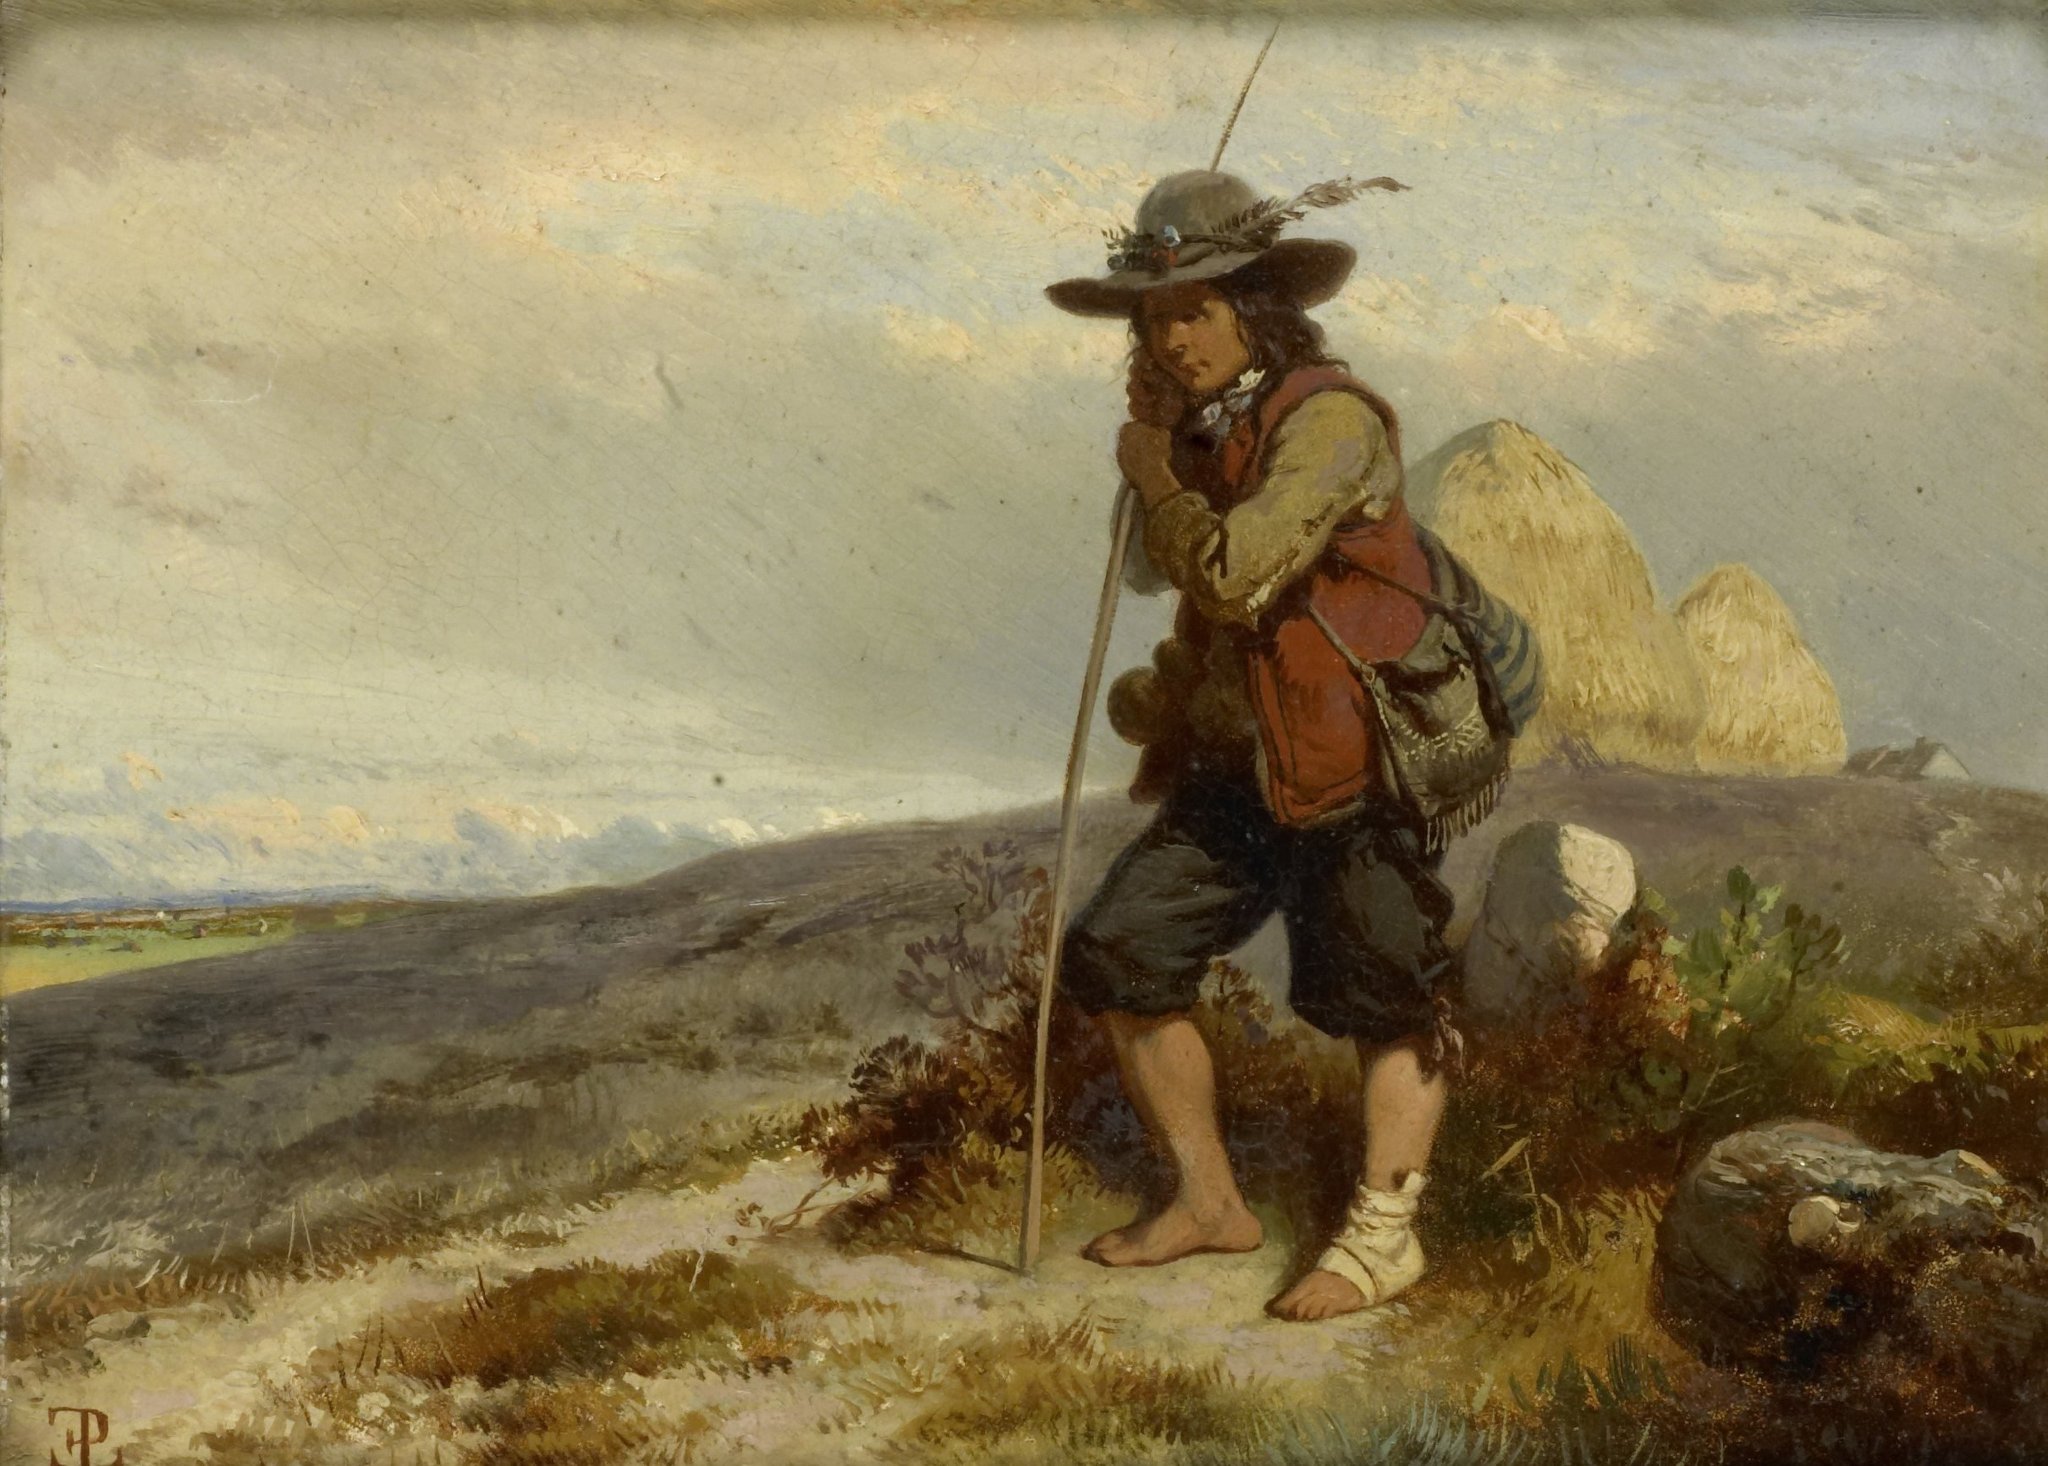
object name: painting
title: A young Herdsman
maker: eugène modeste edmond lepoittevin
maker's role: painter, print maker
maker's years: 1806-1870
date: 1840-1870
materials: board, oil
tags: herding, herdsman, herdswoman, shepherd, shepherdess, cowherd, etc., hay-stack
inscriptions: signature: ‘ELP’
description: Een herdersjongen staande op een heuveltop, leunend op zijn staf. Rechts hooibergen en een boerderij.